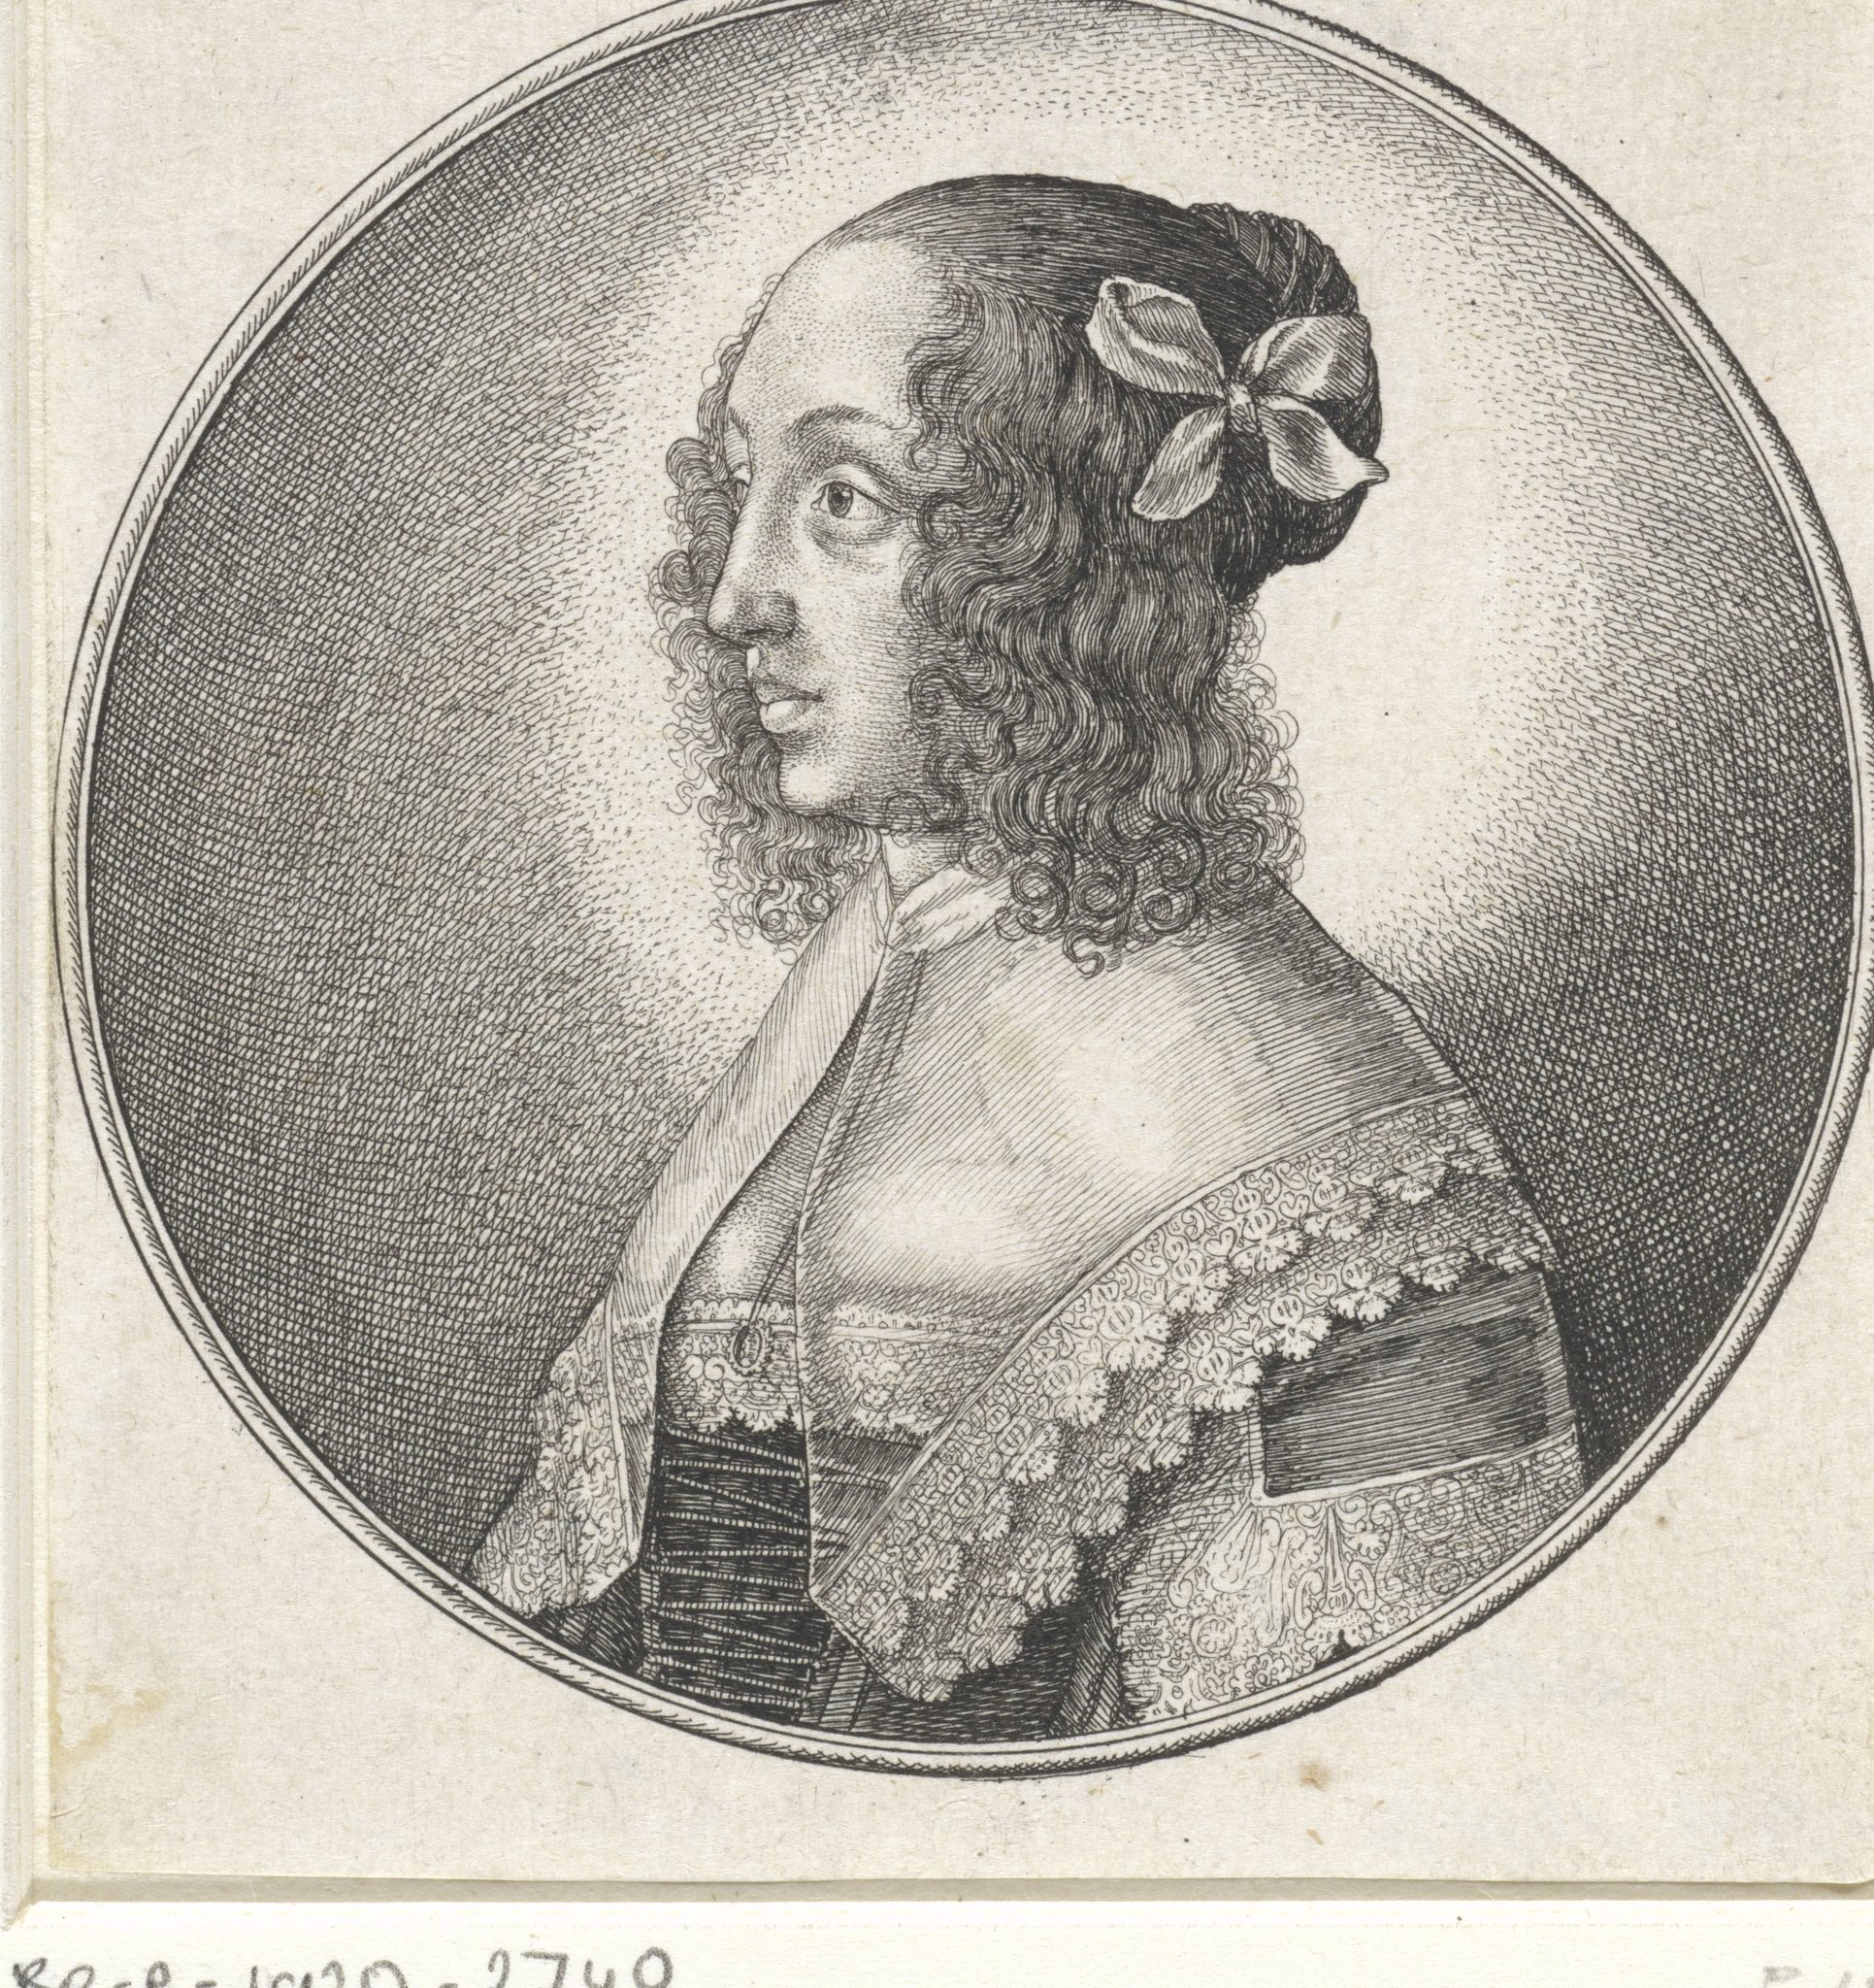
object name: print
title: Vrouw met kanten kraag en strik in het haar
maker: wenceslaus hollar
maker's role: draughtsman, print maker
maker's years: 1607-1677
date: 1642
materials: paper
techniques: etching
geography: london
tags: anonymous historical person portrayed alone - bb - woman, neck-gear: collar (+ women's clothes), bow (ornamental part of clothing)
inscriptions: collector's mark: Lugt 654, inscription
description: De prent maakt deel uit van een 13-delige serie met vrouwenbusten in medaillons.